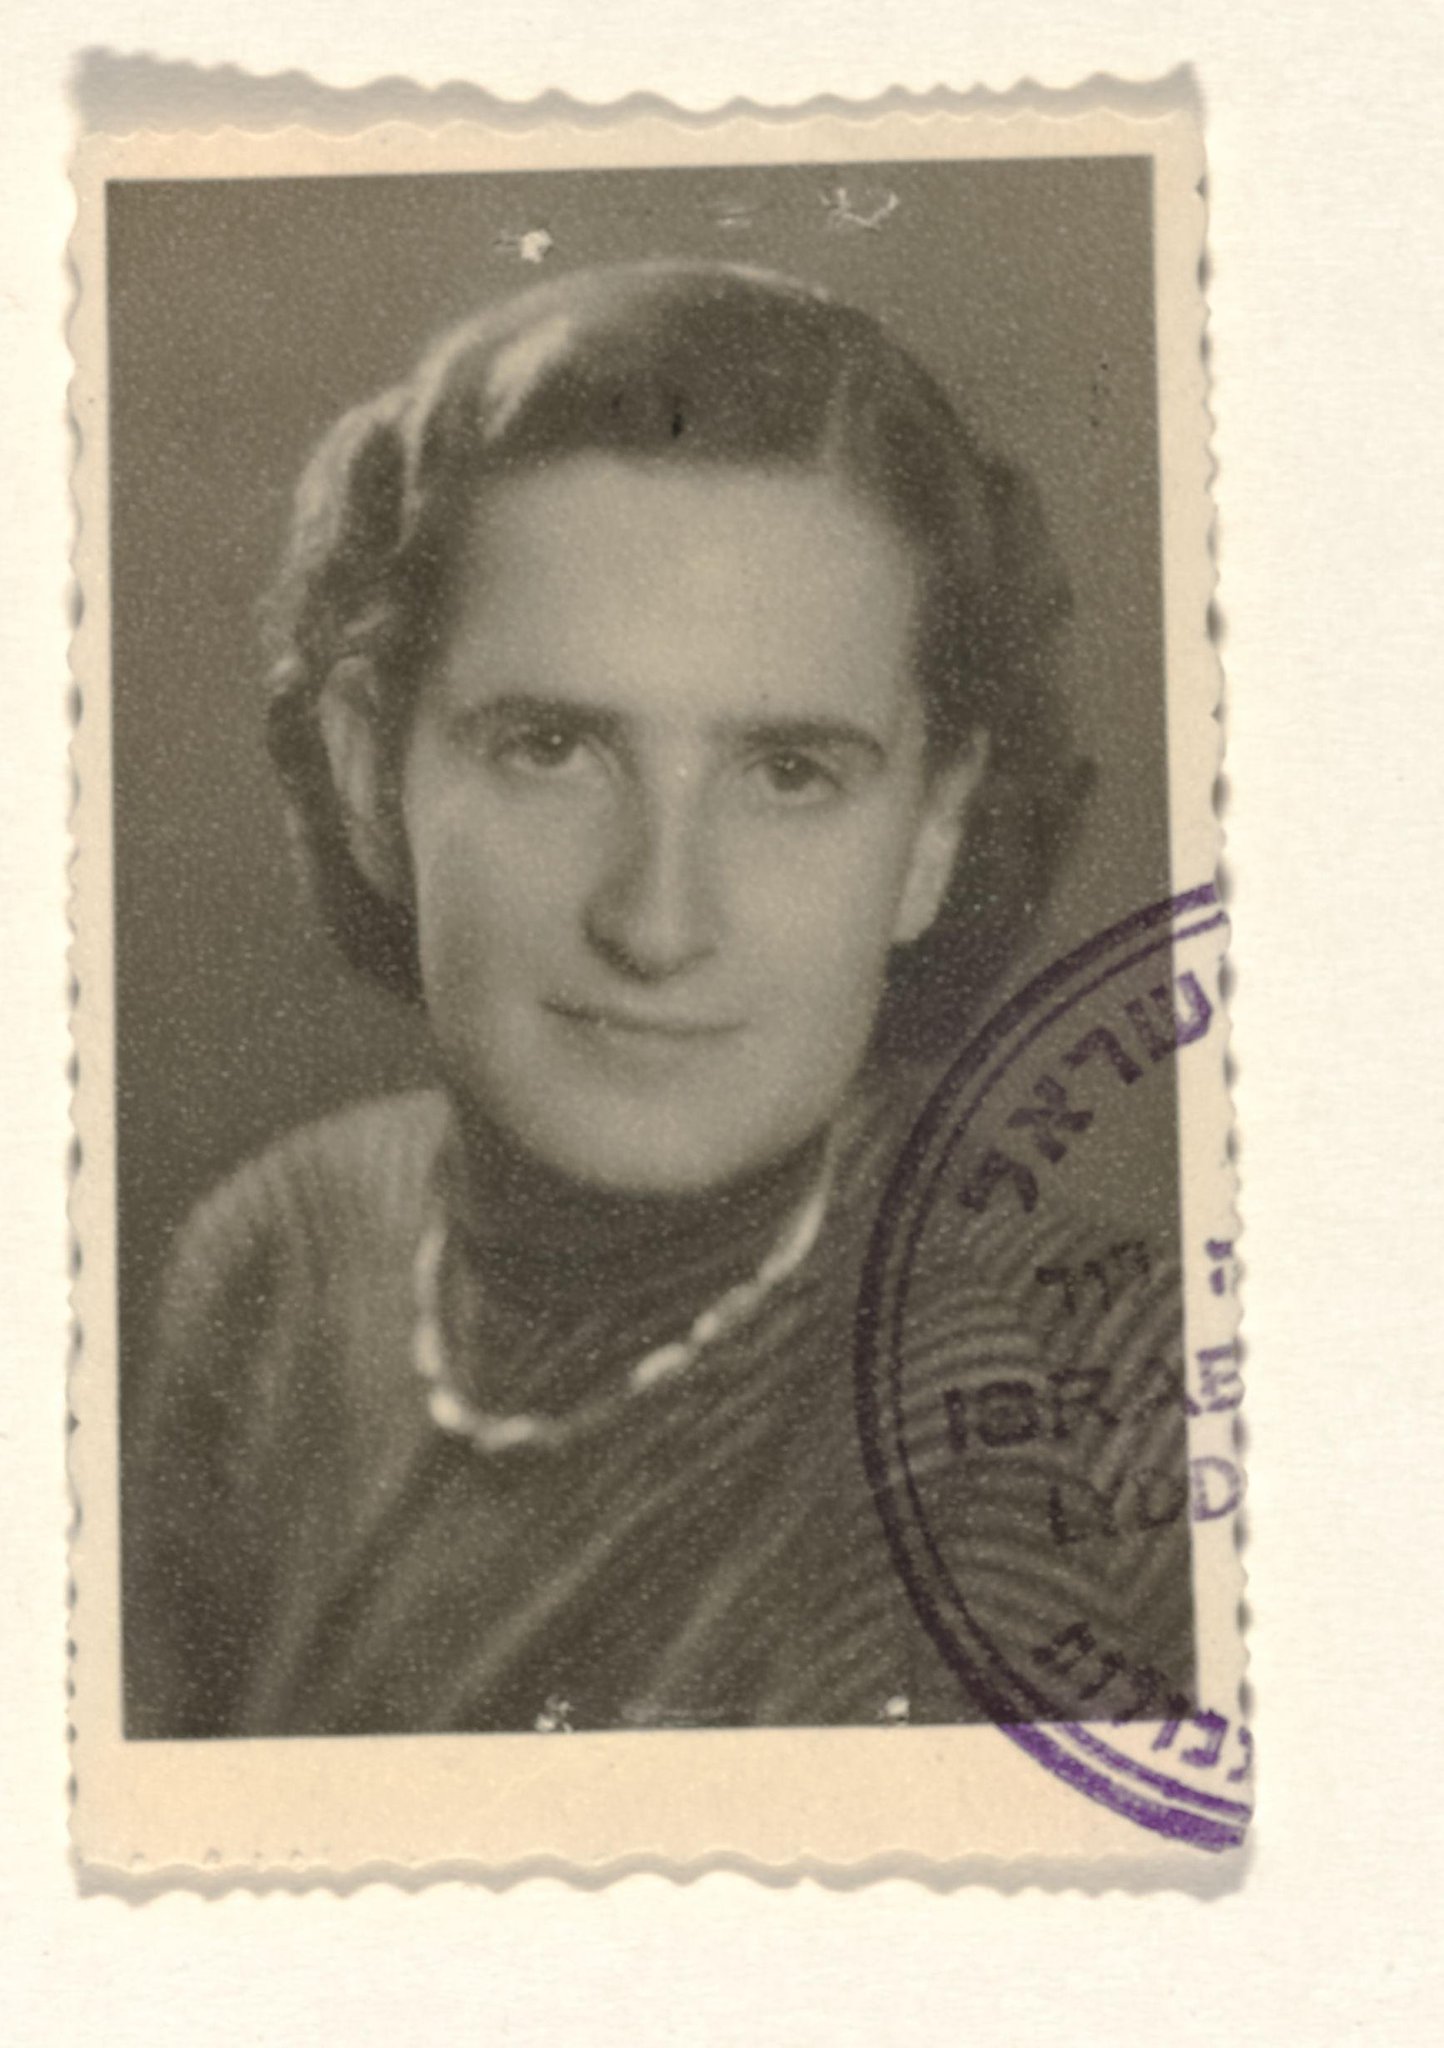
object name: photograph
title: Portret van Isabel Wachenheimer in gestreepte trui en met halsketting, met Israëlisch stempel op de voorzijde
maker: Anonymous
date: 1947-1955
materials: photographic support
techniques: gelatin silver print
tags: leiden, isabel wachenheimer-elon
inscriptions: number: ‘3023’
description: Portret van Isabel Wachenheimer in gestreepte trui en met halsketting, met Israëlisch stempel op de voorzijde.